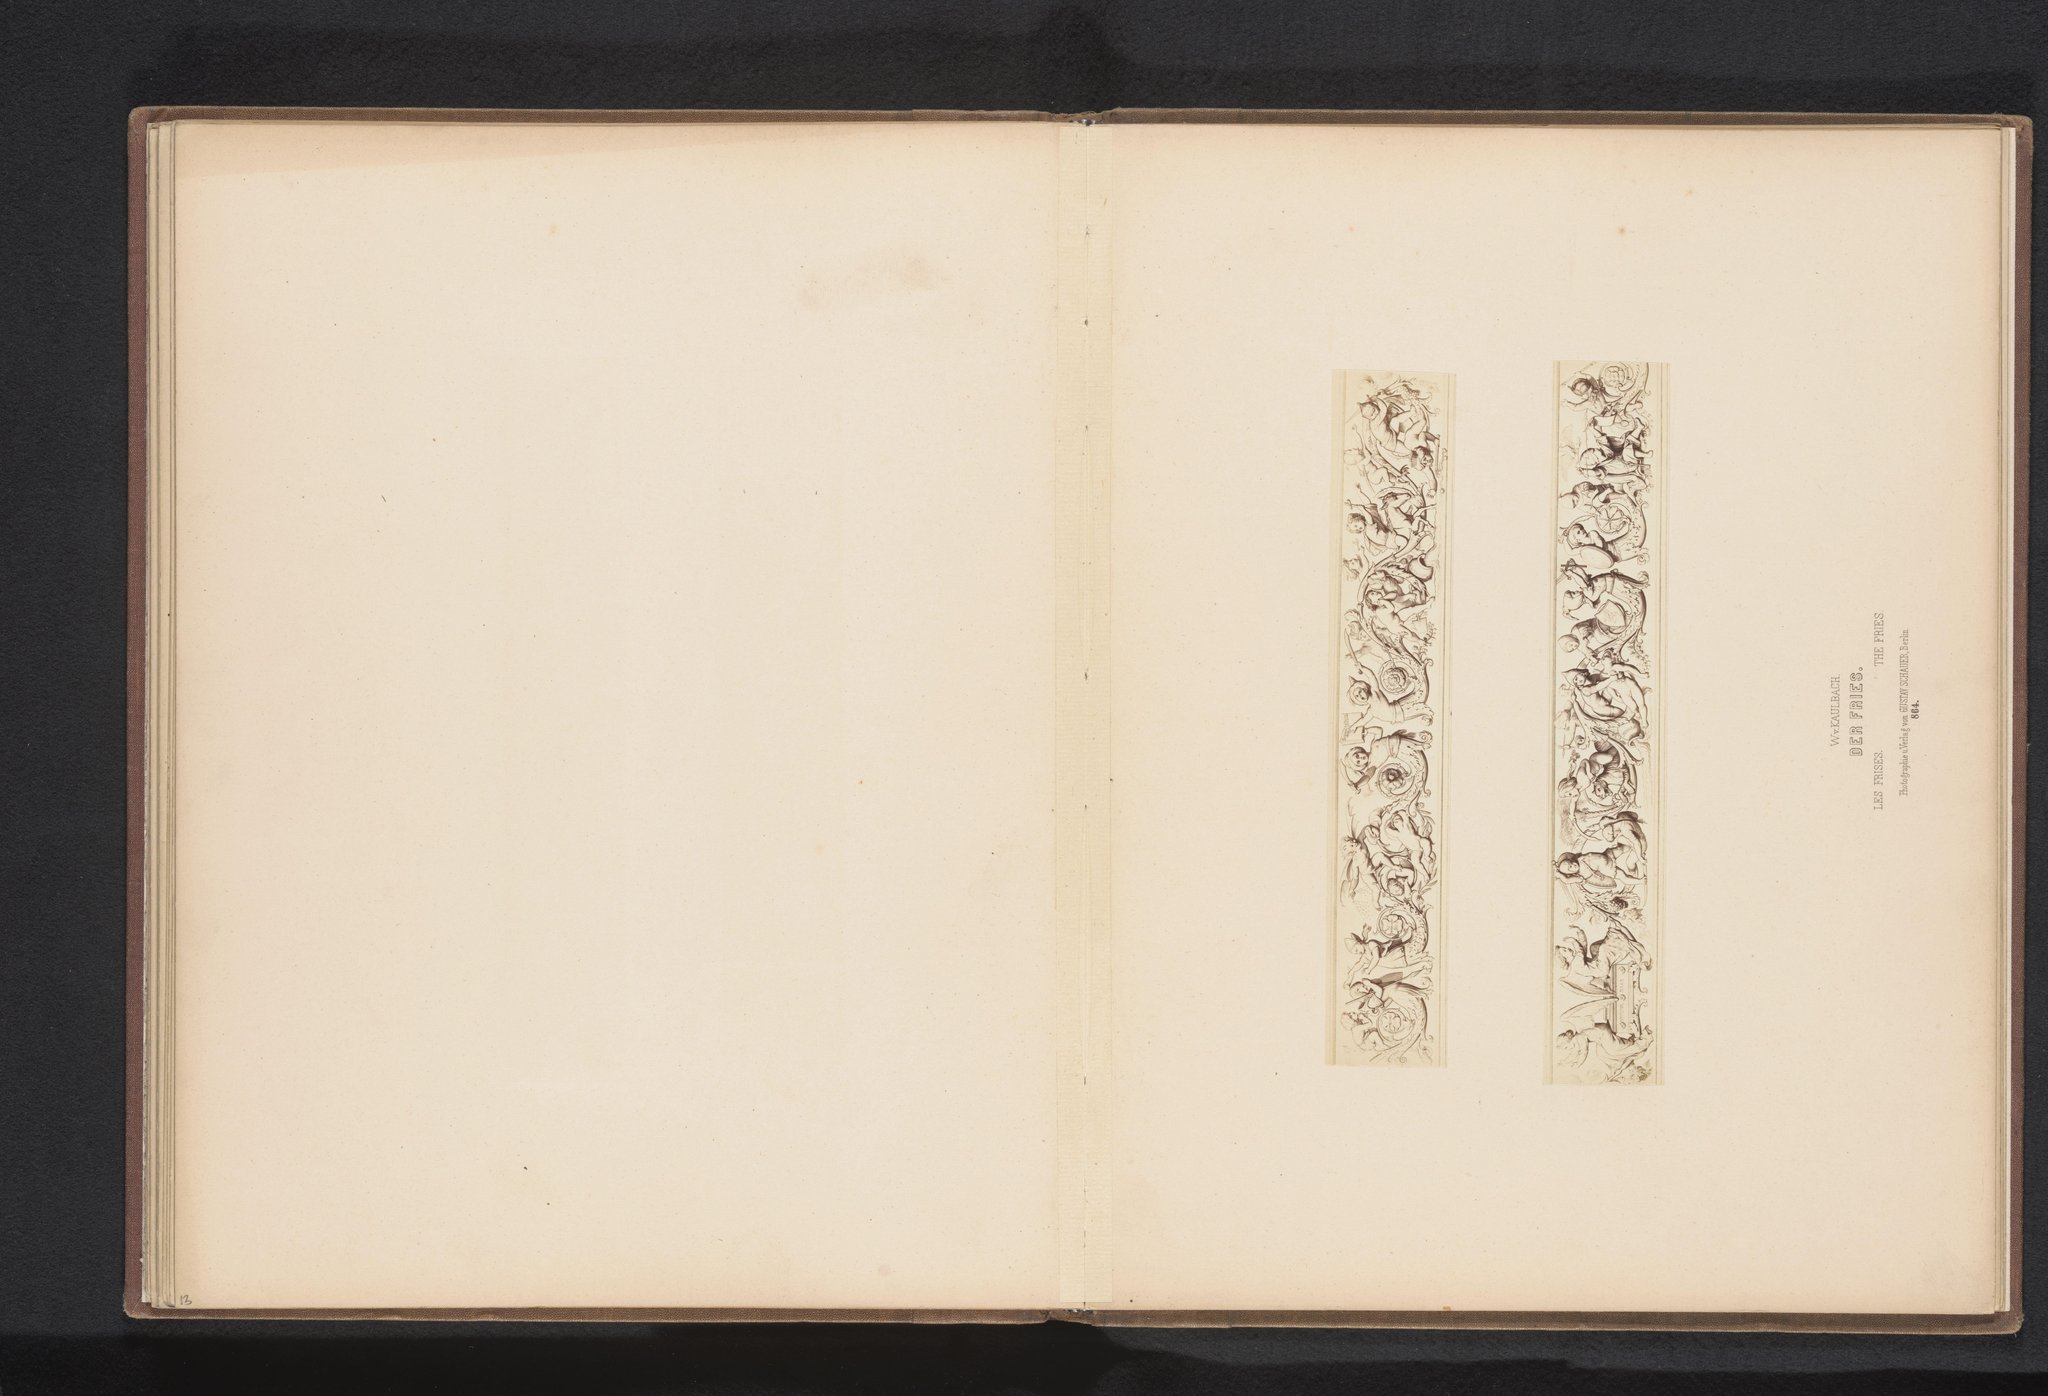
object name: photograph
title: Fotoreproducties van twee tekeningen voor decoratieve friezen voor wandschilderingen voor het trappenhuis van het Neues Museum in Berlijn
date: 1860-1870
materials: photographic support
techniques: albumen print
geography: berlin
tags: wall-covering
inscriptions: number: ‘864.’